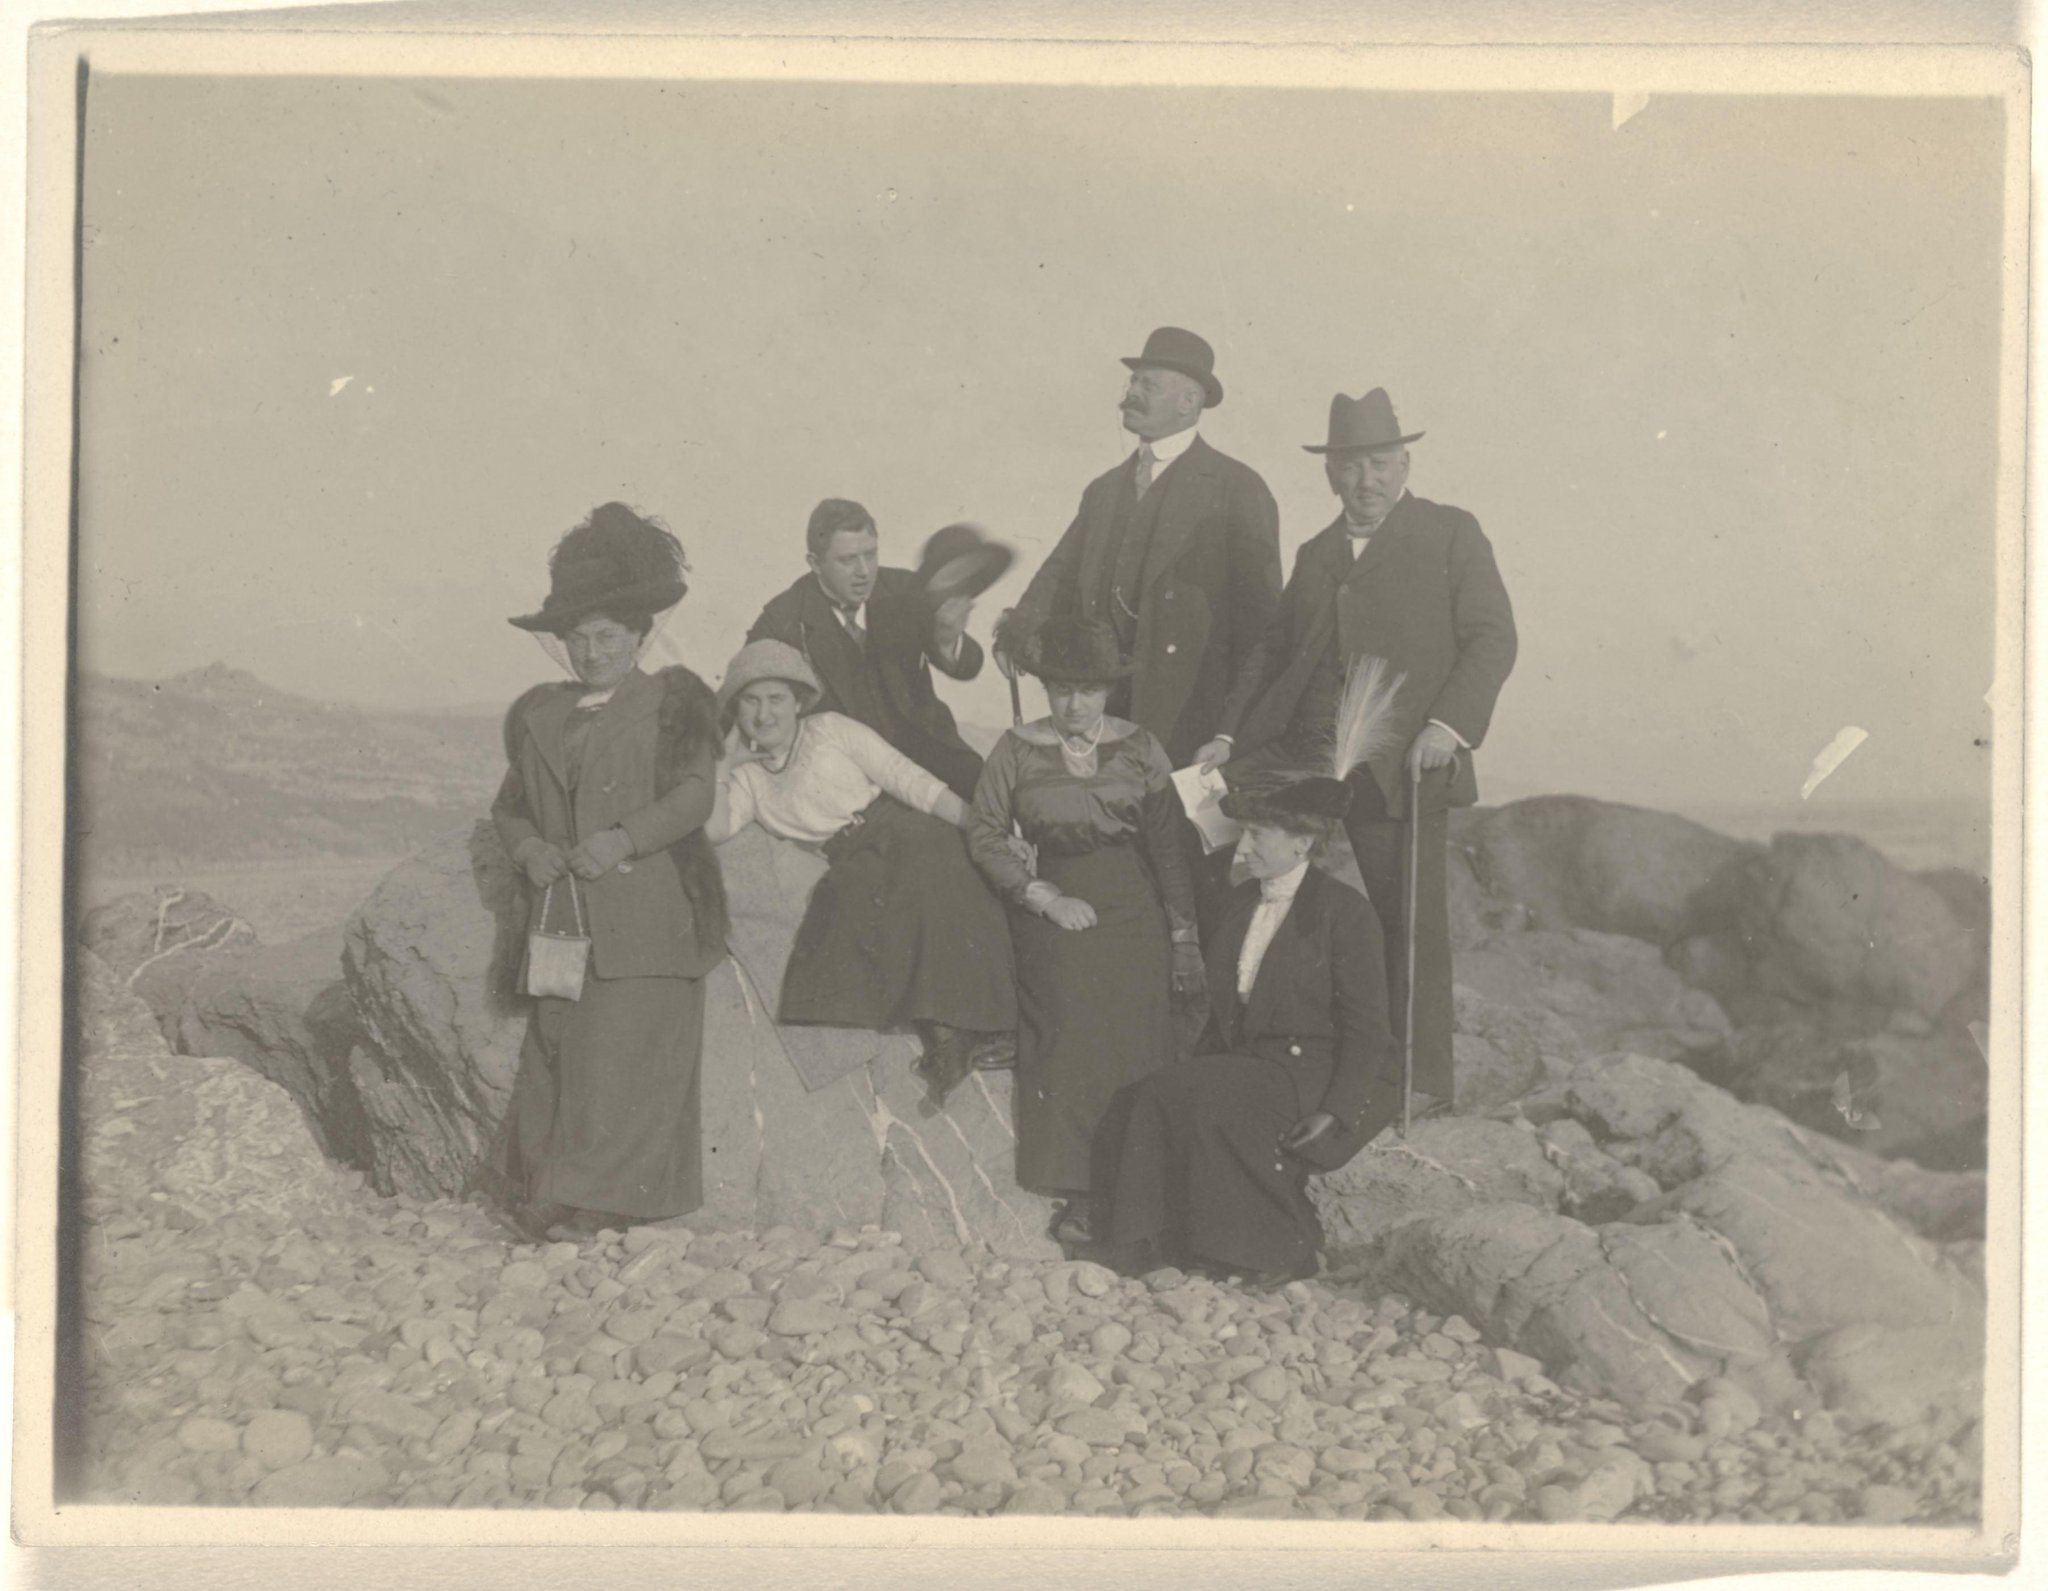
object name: photograph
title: Josefine Moos-Levi, Hermann Moos, Else Wachenheimer-Moos en vier onbekende mensen, zittend op rotsen in een woestijnachtig rotslandschap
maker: Anonymous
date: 1911-1928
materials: photographic support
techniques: gelatin silver print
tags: else wachenheimer-moos, josefine moos-levi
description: Josefine Moos-Levi (1e van links), Hermann Moos (1e van rechts), Else Wachenheimer-Moos (2e van links) en vier onbekende mensen, zittend op rotsen in een woestijnachtig rotslandschap